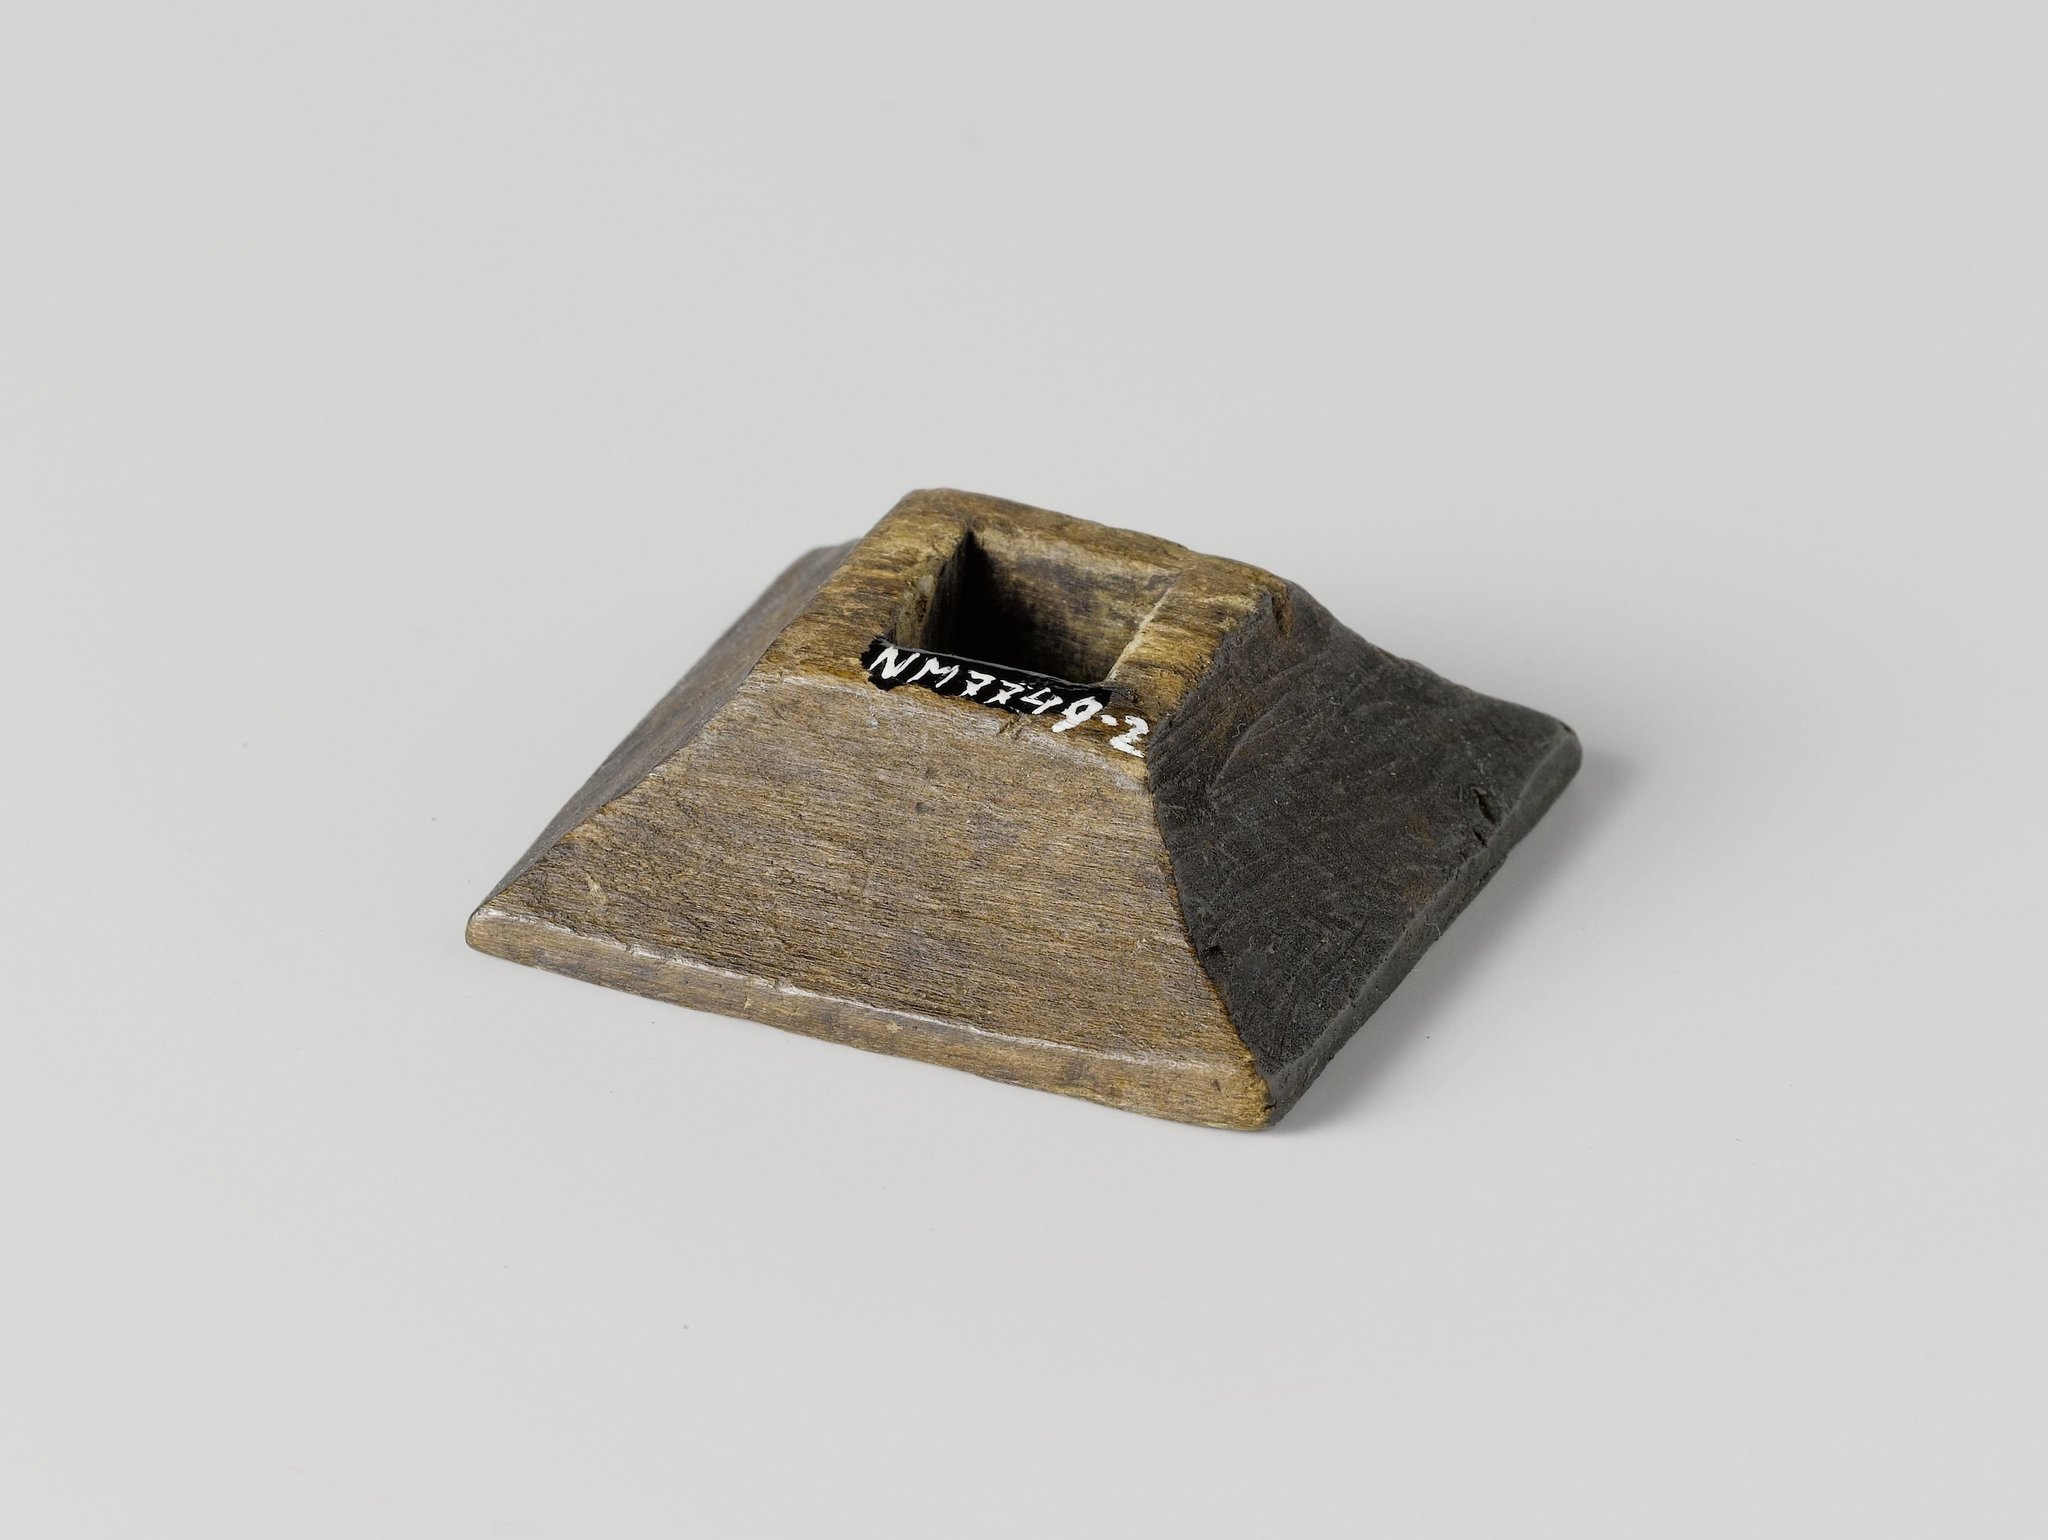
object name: graadstok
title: Schuif van hout, vierkant van vorm met een vierkant gat behorend bij een Jacobsstaf of graadstok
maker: Anonymous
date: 1590-1596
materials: wood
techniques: cutting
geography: amsterdam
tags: willem barendsz., amsterdam, jacob van heemskerck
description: Vierkante schuif of kruis van hout met in het centrum een vierkant gat en schuin omhooglopende wanden. Onderdeel van een Jacobsstaf of graadstok, maar niet behorend bij NG-NM-7749-1.